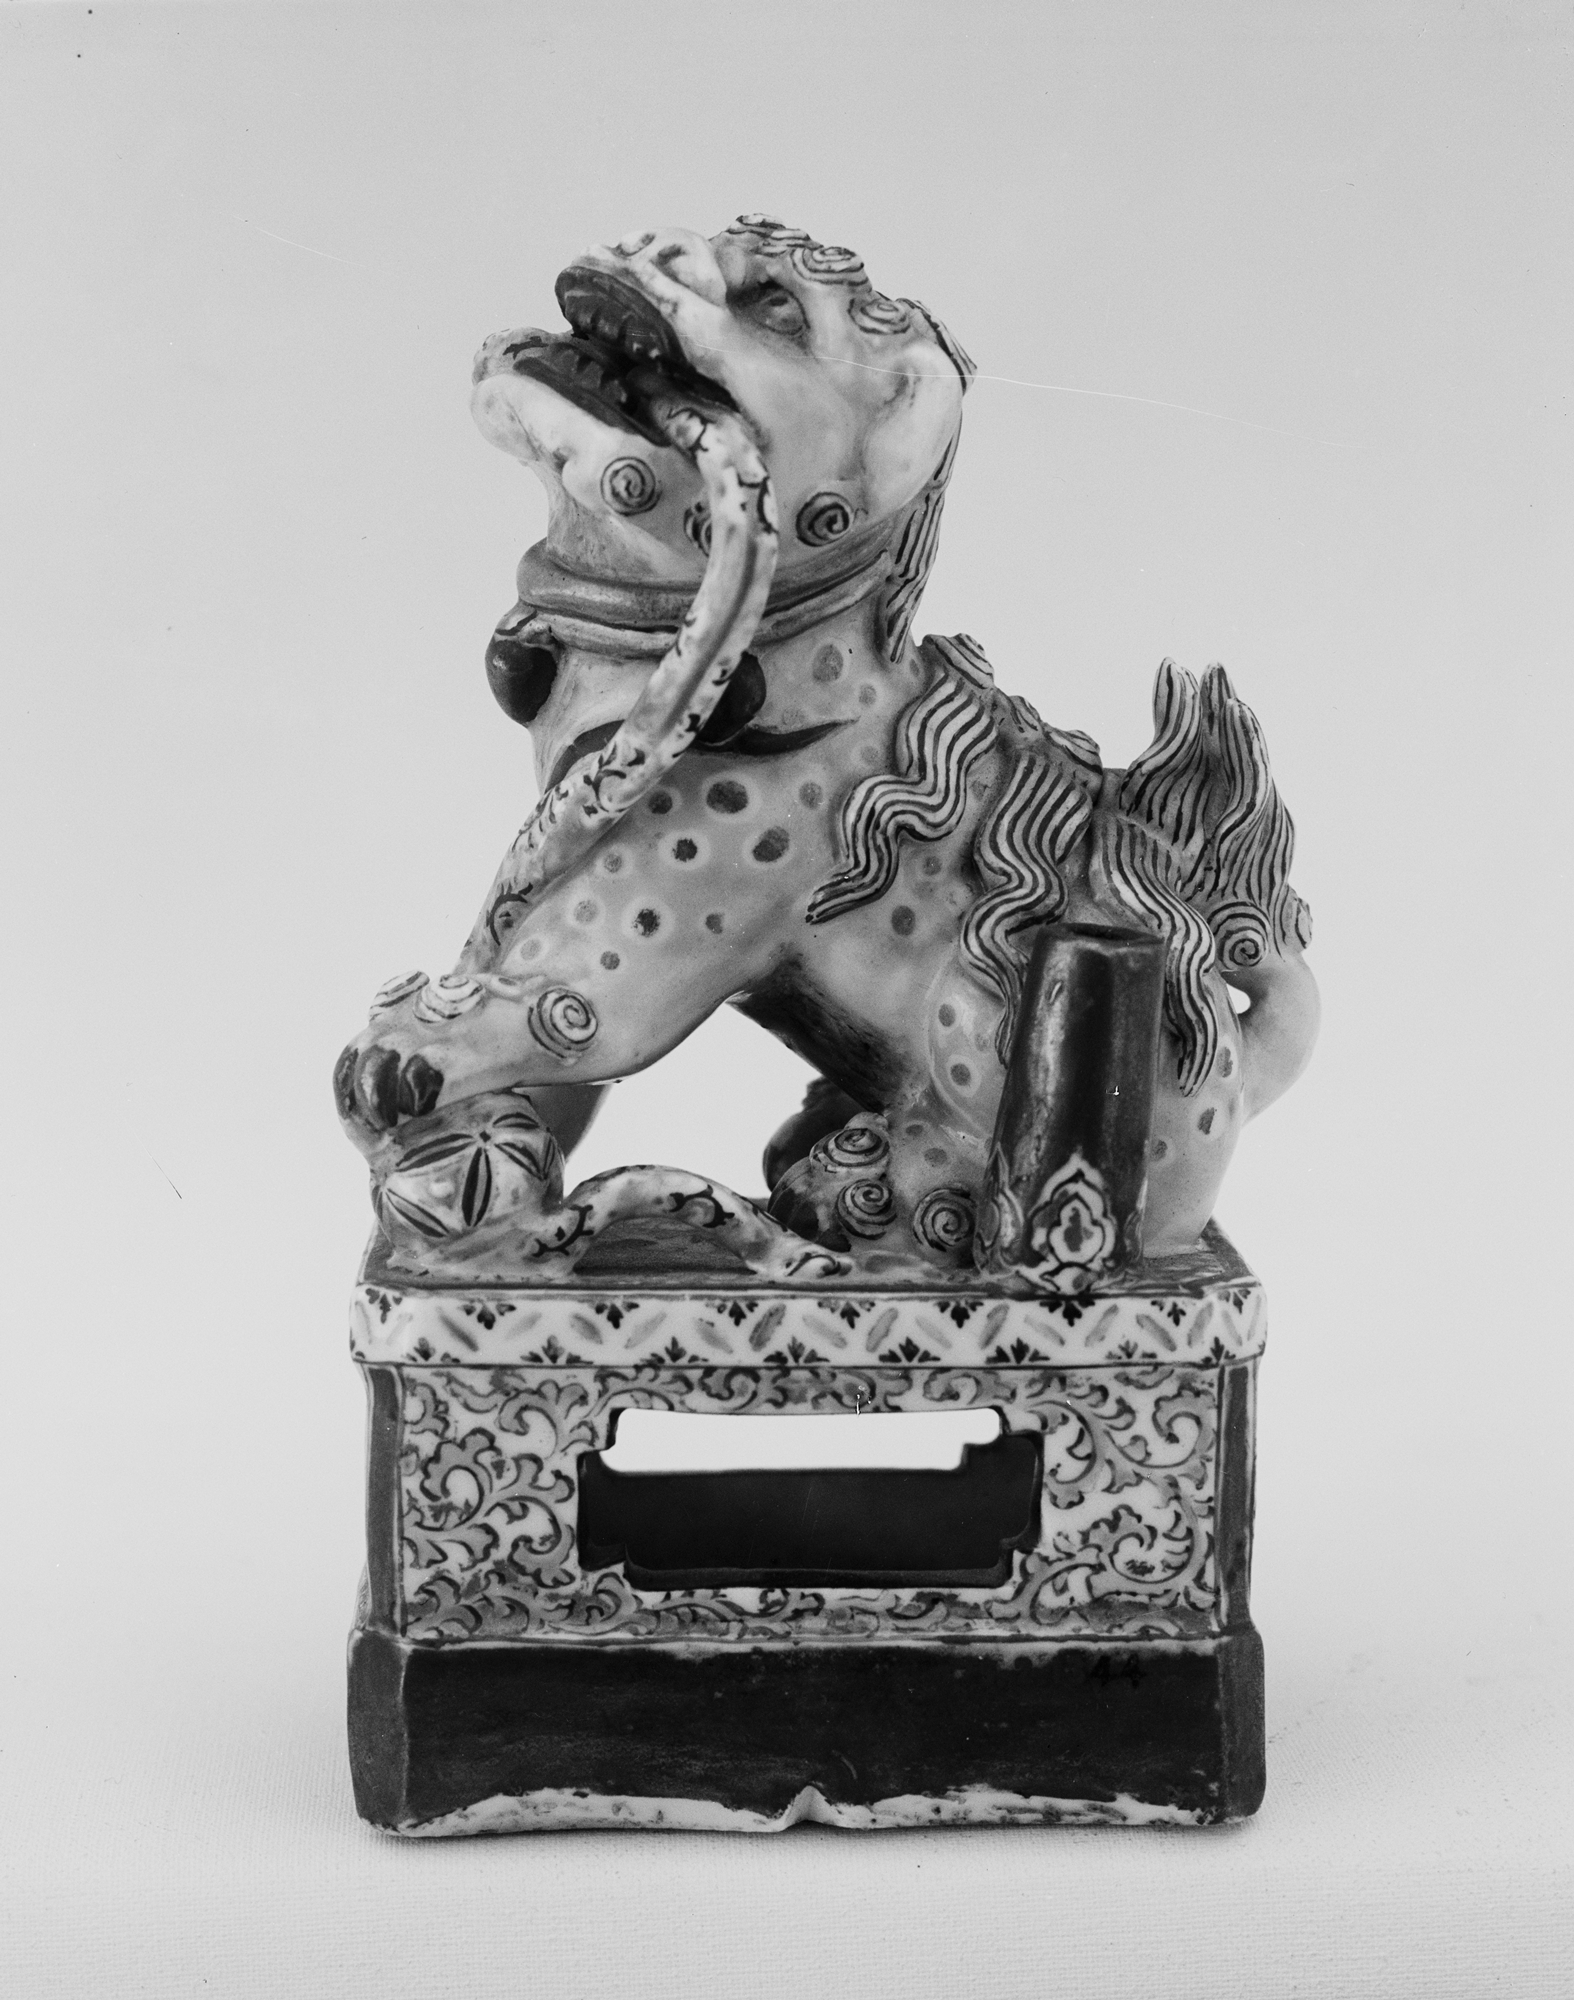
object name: figure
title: Figure of a Lion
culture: japanese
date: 1701-1800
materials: enamel, porcelain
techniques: polychrome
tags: lions